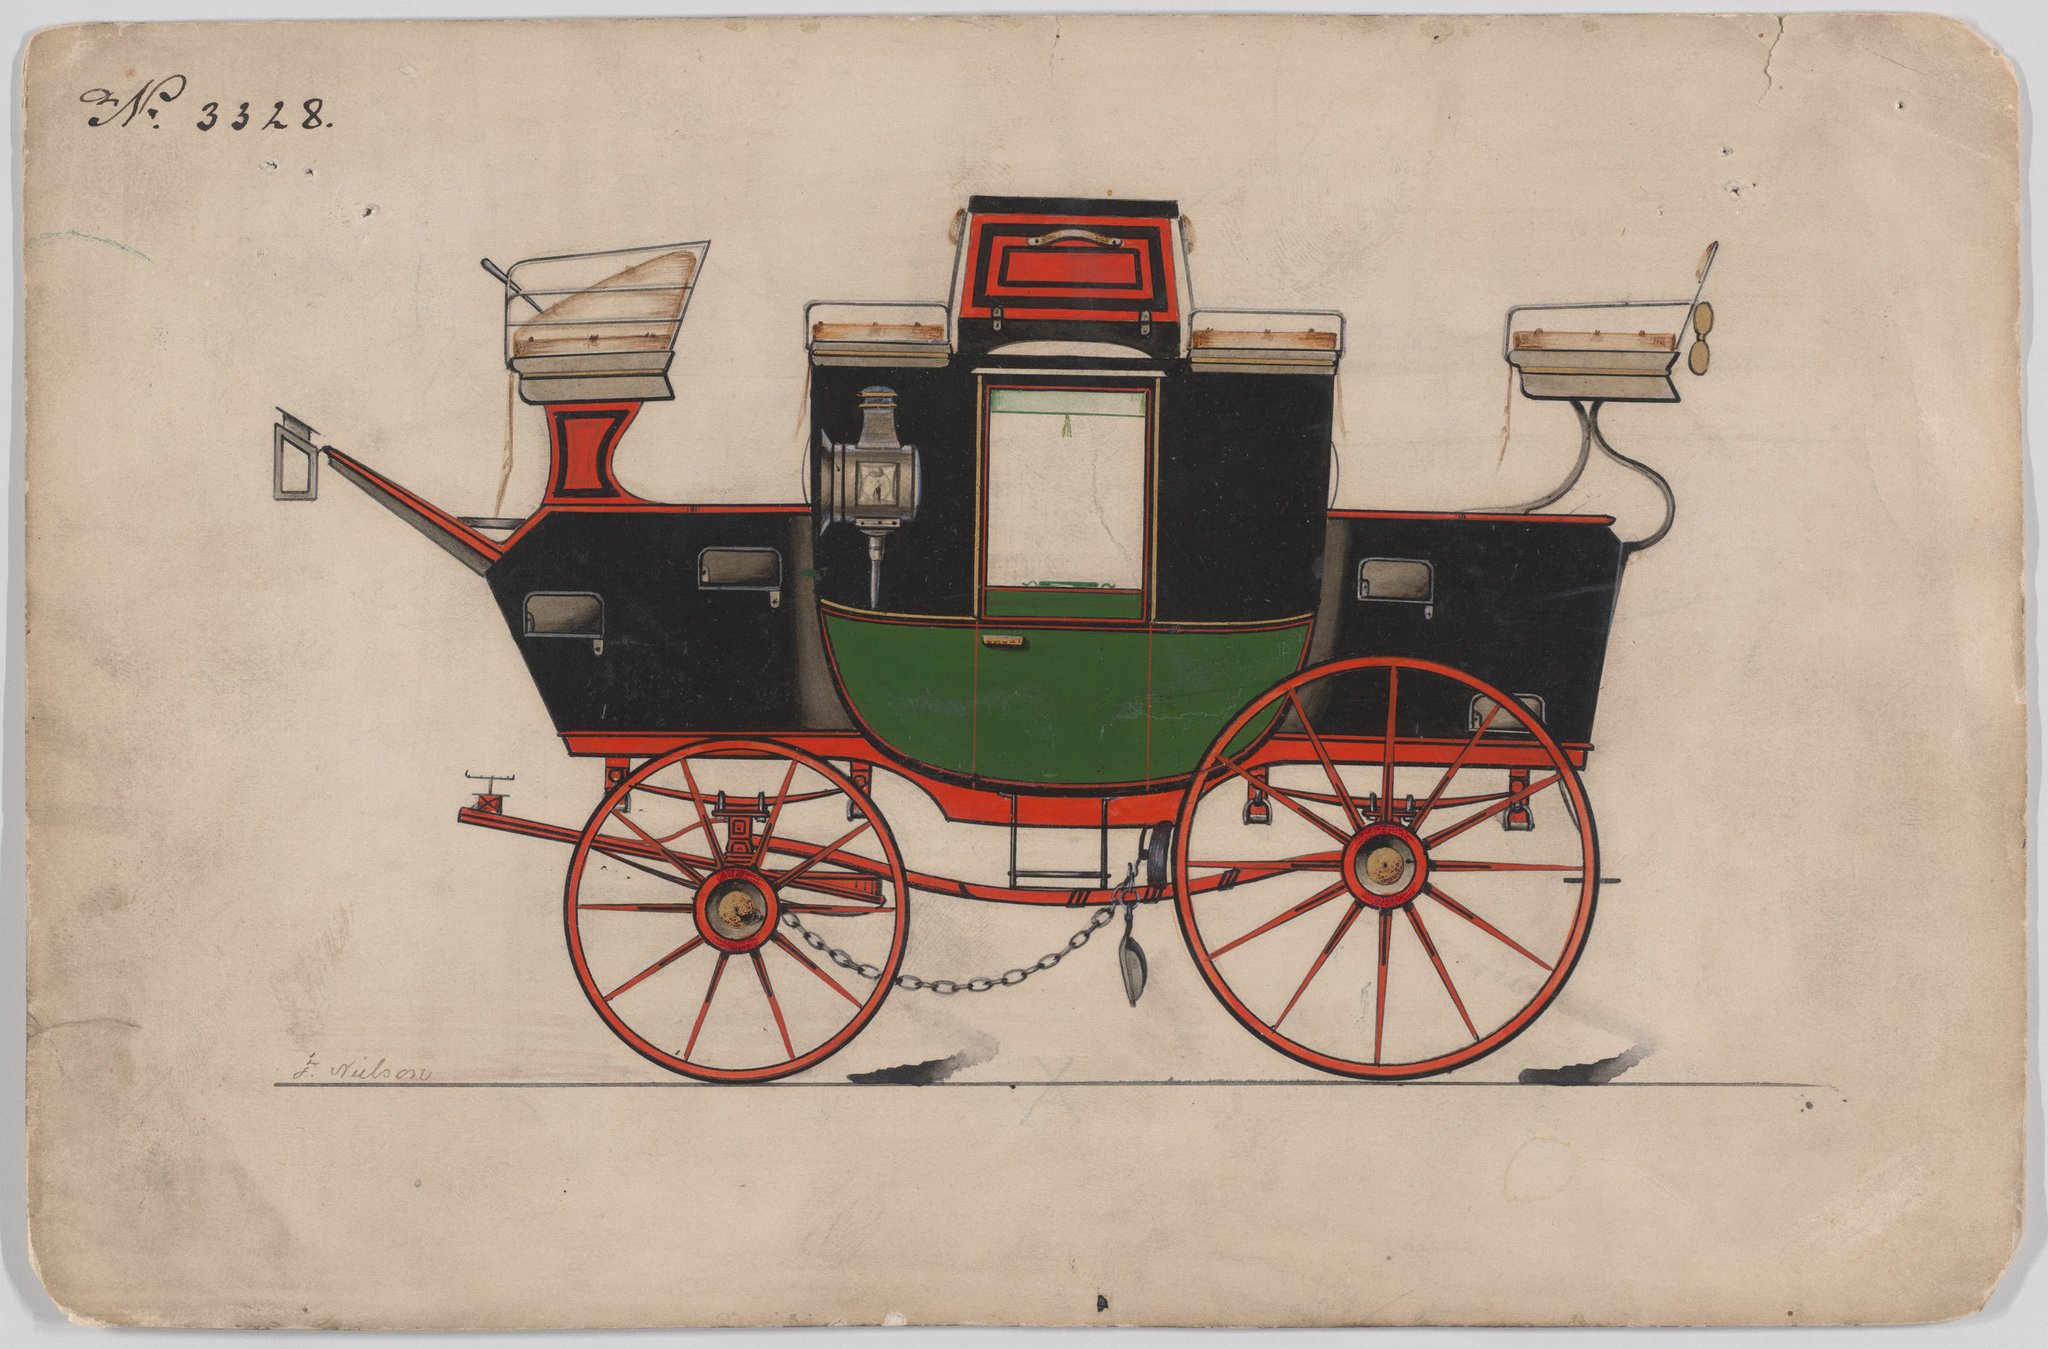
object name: drawing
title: Park Drag #3328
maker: brewster & co.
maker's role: manufacturer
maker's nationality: american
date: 1876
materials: gouache, gum arabic, ink, paint, watercolor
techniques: pen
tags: carriages